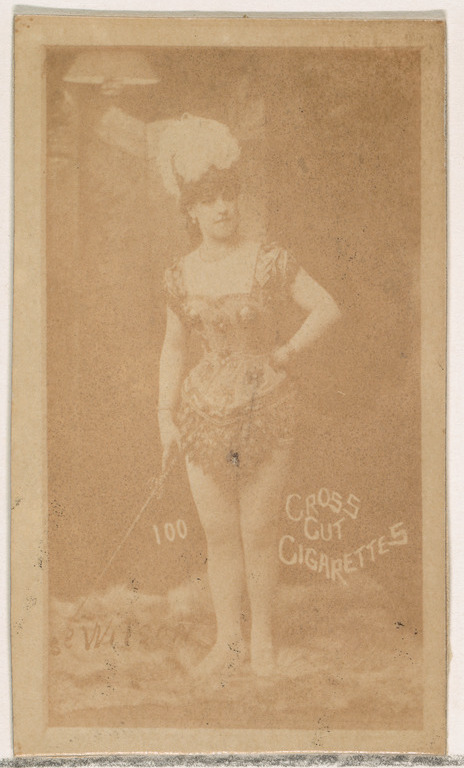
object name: print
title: Card Number 100, Wilson, from the Actors and Actresses series (N145-1) issued by Duke Sons & Co. to promote Cross Cut Cigarettes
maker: w. duke, sons & co.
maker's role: publisher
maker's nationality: american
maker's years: 1870-1920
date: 1880-1889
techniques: albumen silver print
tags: portraits,women,actresses